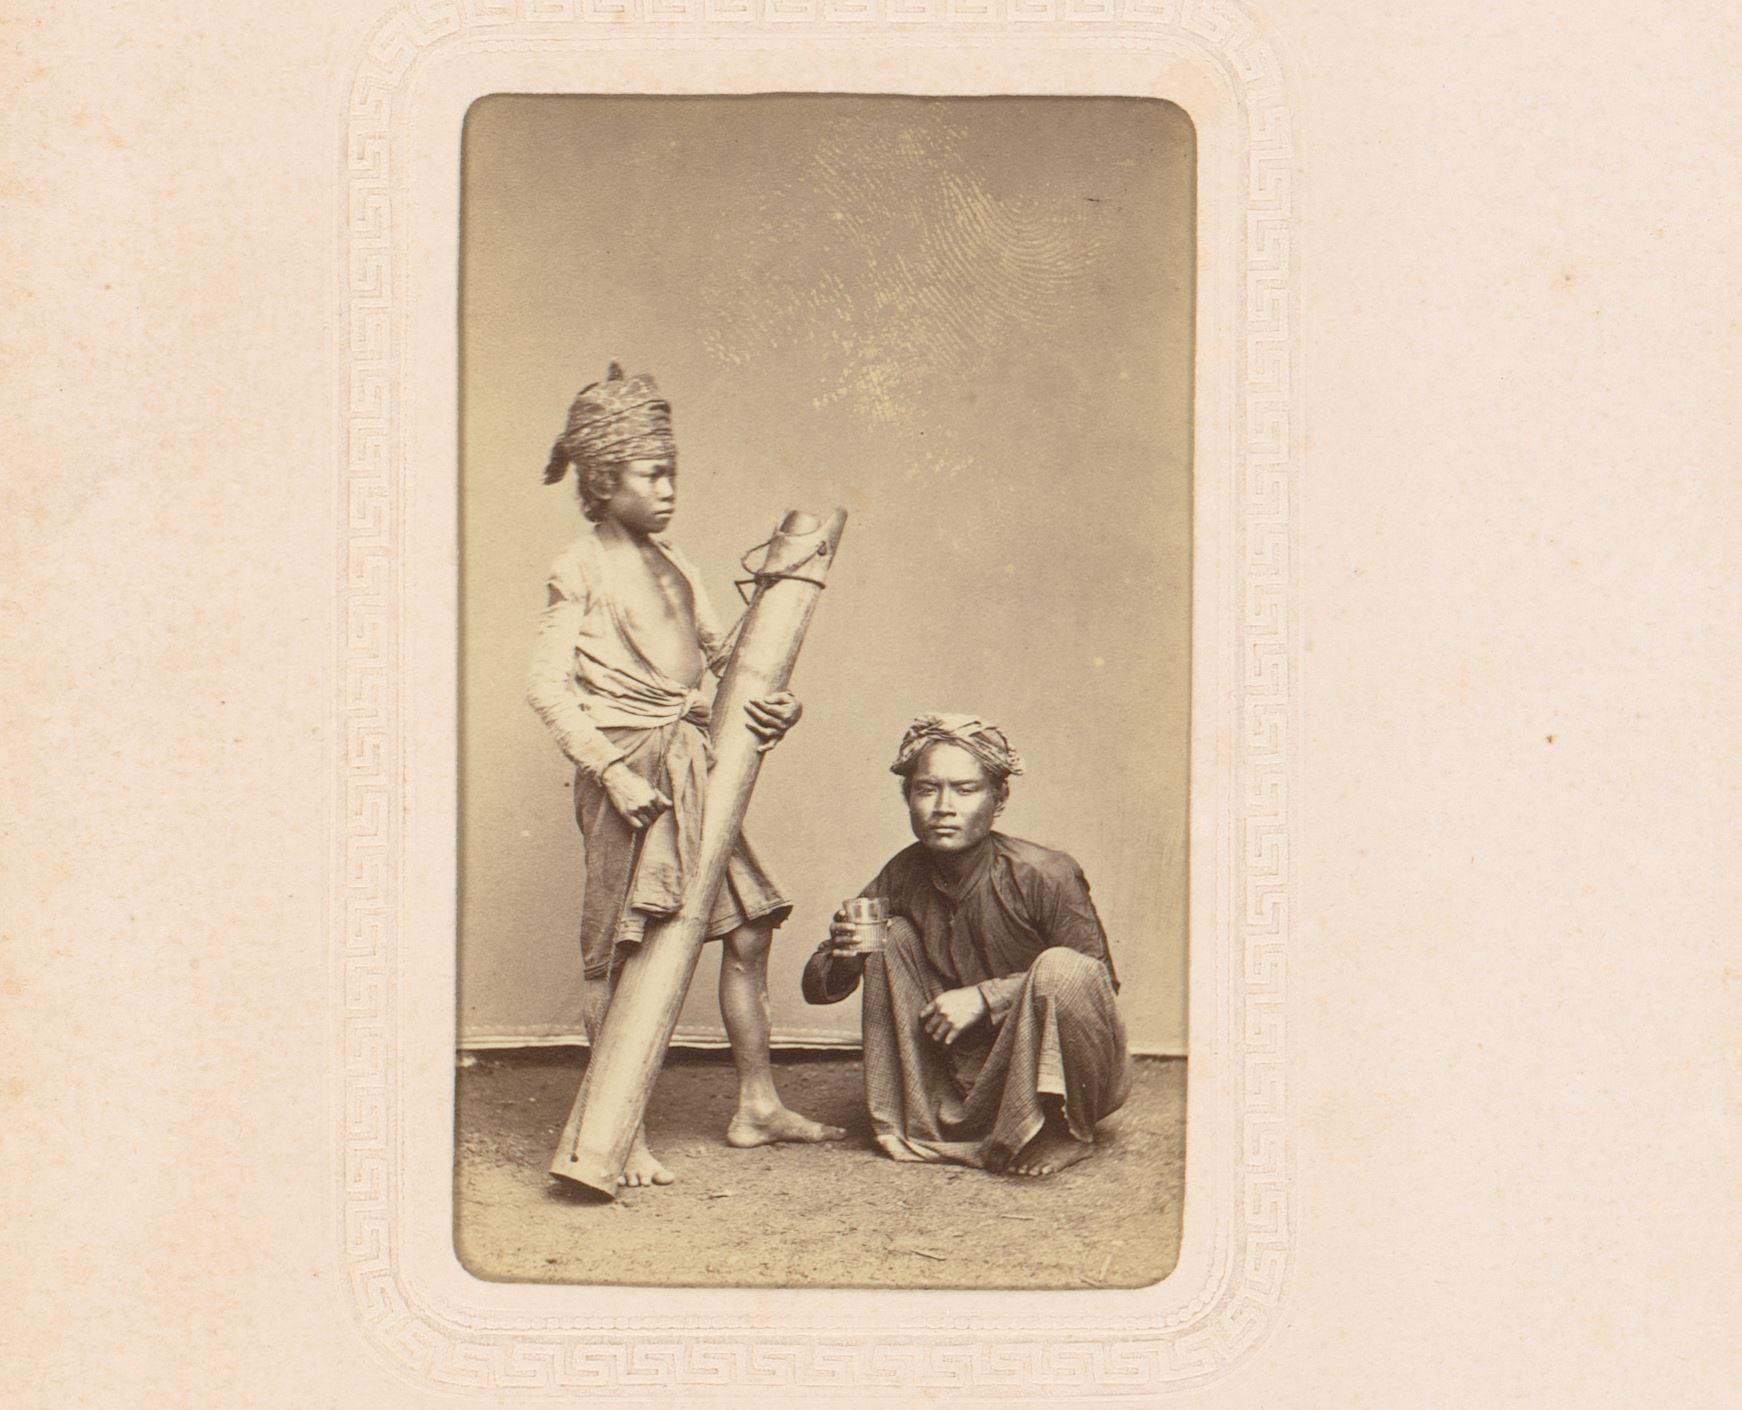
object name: carte de visite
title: Twee Indonesische muzikanten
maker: Anonymous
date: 1850-1870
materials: cardboard, photographic support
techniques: albumen print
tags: musician at work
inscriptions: number: ‘39’